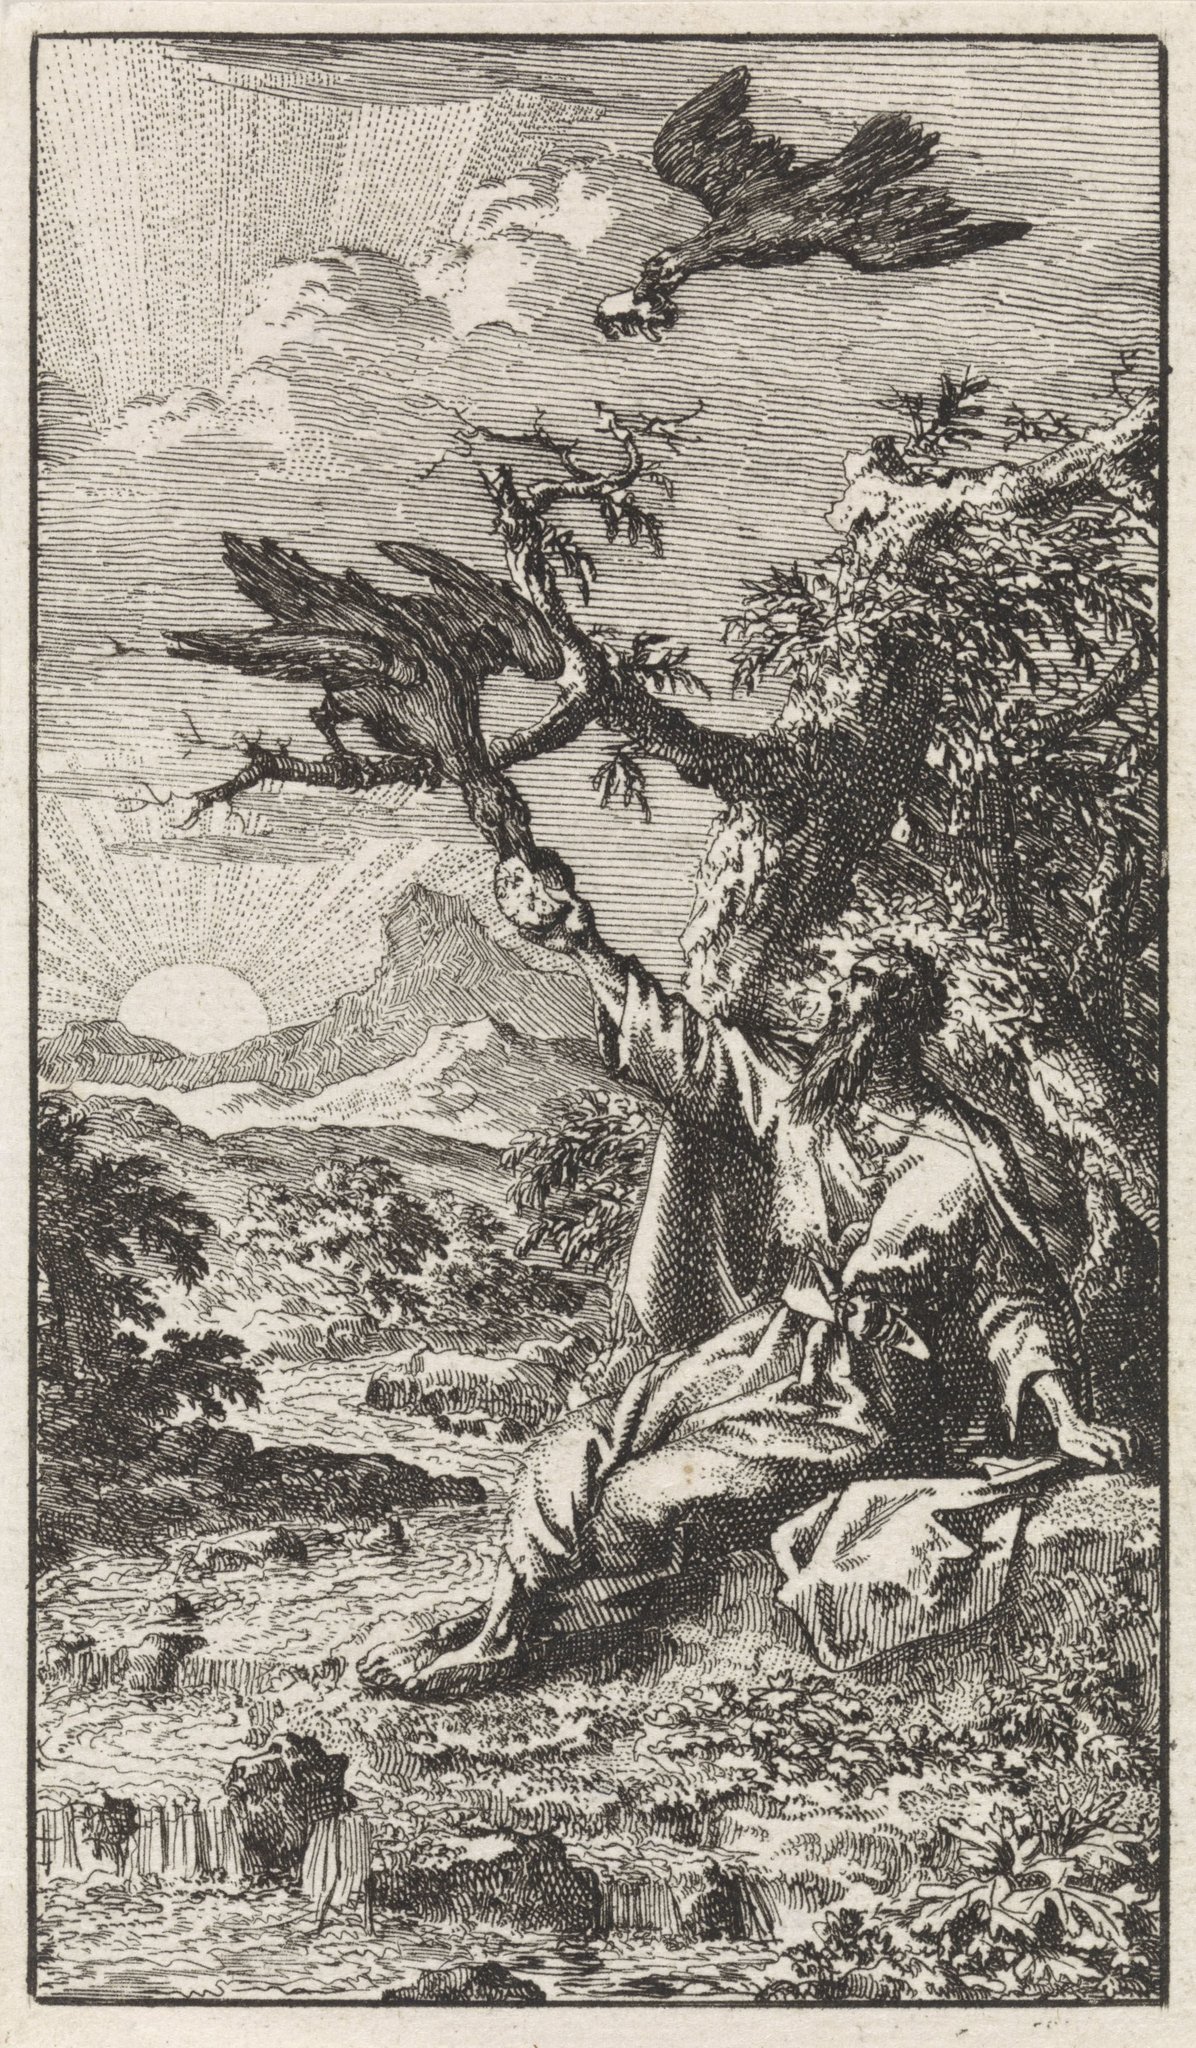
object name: print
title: Elia gevoed door raven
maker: jan luyken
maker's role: draughtsman, print maker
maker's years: 1649-1712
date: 1712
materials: paper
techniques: etching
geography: amsterdam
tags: elijah fed by the raven(s): while the prophet is living by the brook, ravens bring him food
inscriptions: collector's mark: Lugt 2228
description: Proefdruk van illustratie voor: Luyken, Jan. Bybel printen. Amsterdam: Pieter Arentsz. II (wed.) en Cornelis van der Sys, 1712, p. 12.